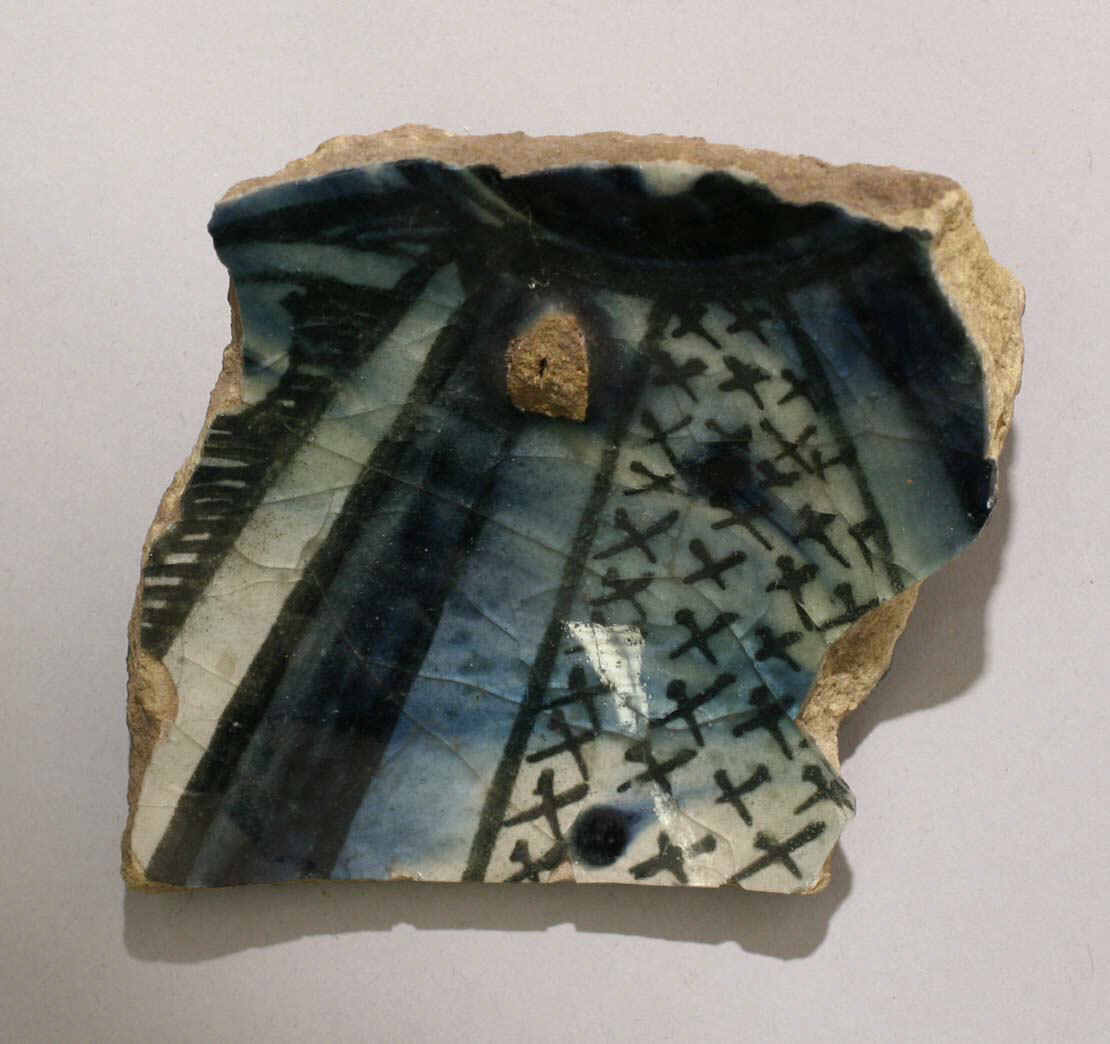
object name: fragment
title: Ceramic Fragment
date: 1301-1400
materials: stonepaste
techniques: painting, polychrome, underglaze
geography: egypt or syria